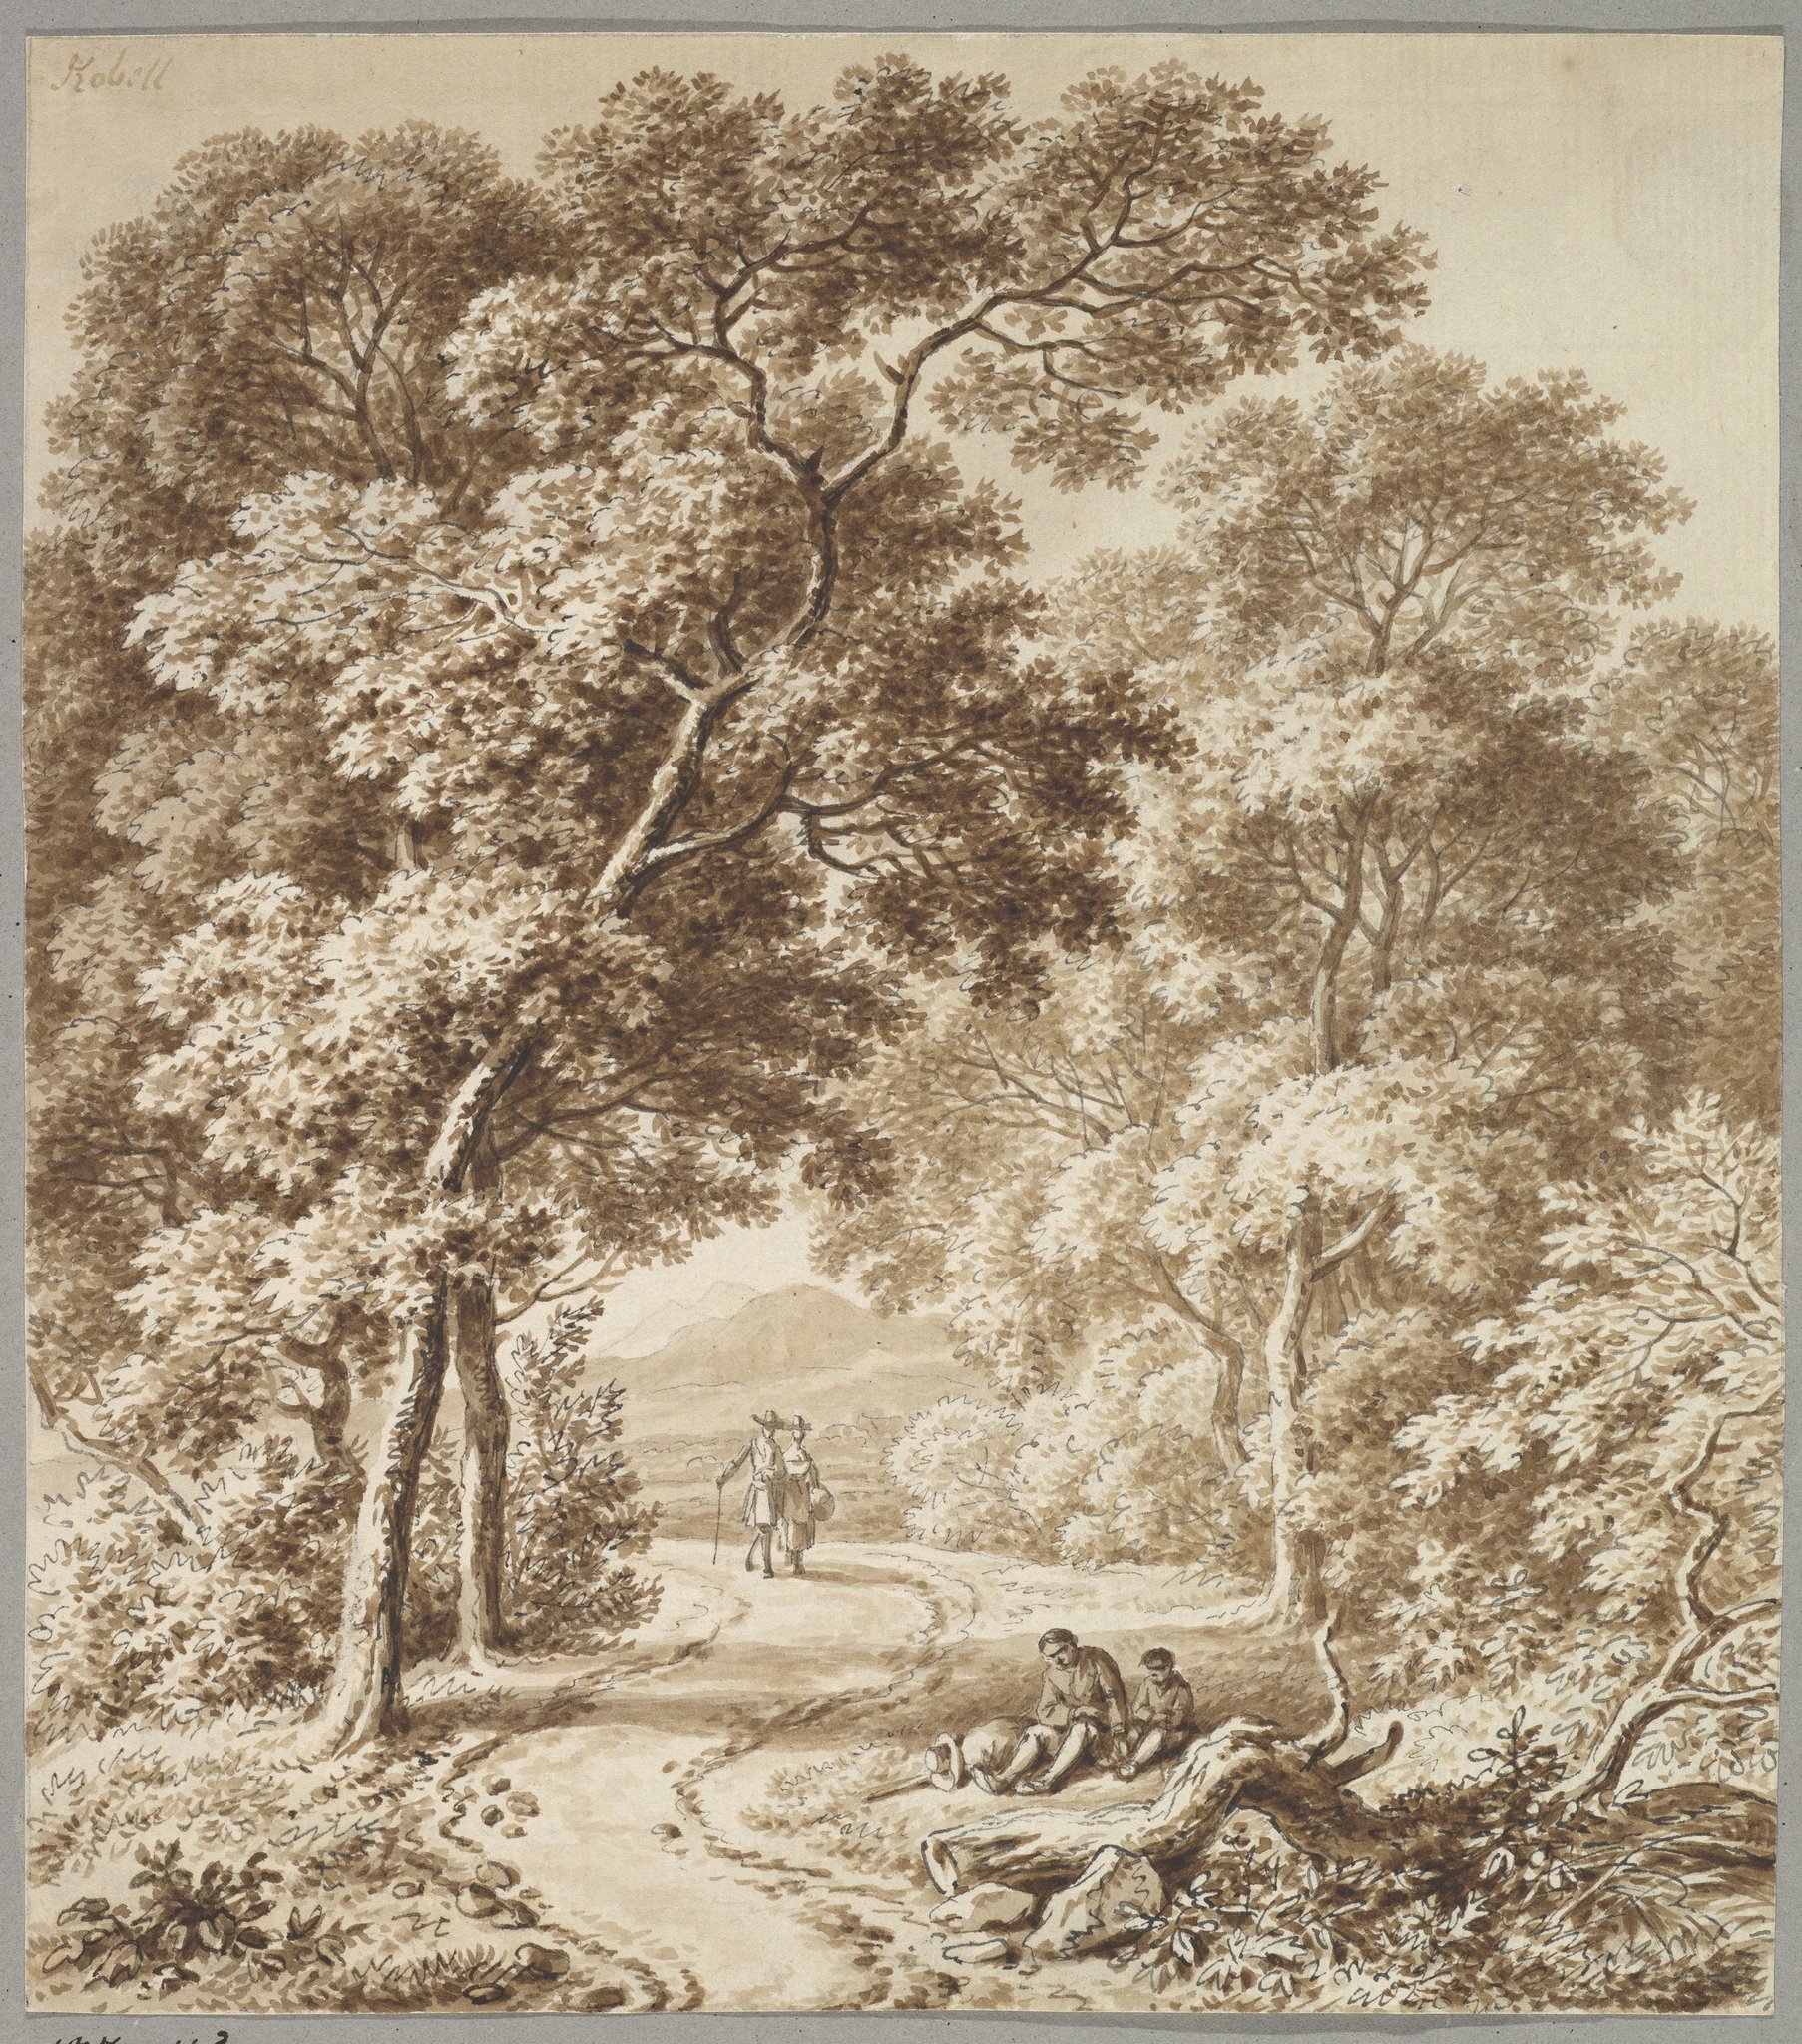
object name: drawing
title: A Path Bordered by Trees with two Beggars and a Couple Strolling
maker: ferdinand kobell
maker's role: artist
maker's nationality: german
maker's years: 1740-1799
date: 1767-1800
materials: chalk, graphite, ink, paper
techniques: brush, pen, wash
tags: human figures,roads,landscapes,trees